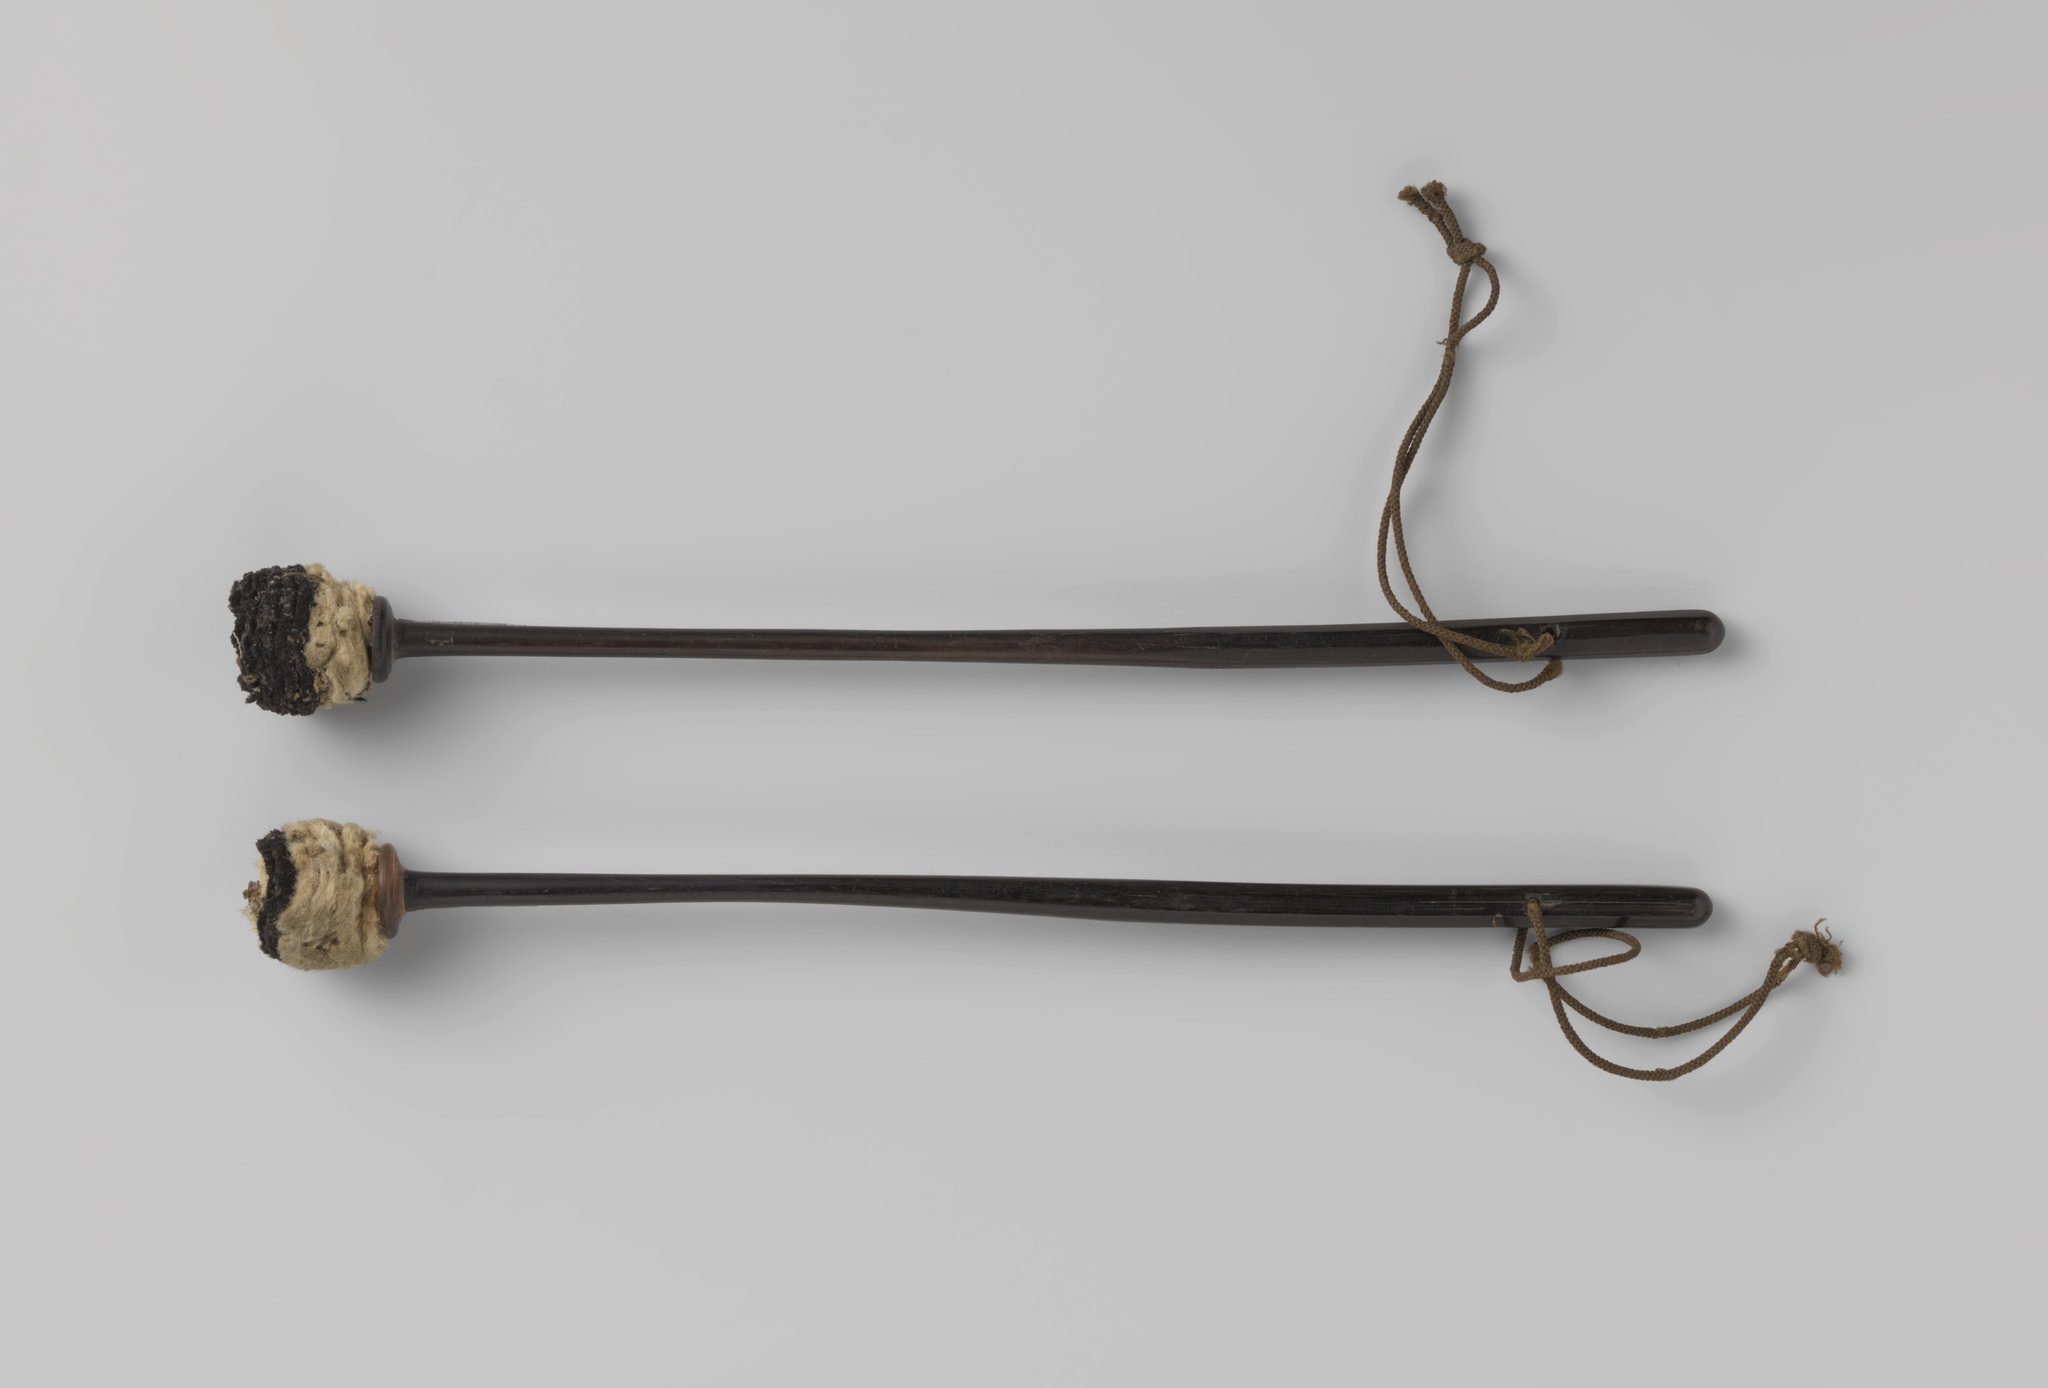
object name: element of musical instrument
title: Timpani hammers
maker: Anonymous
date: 1800-1893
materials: wood, wool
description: Paukenstokken van hout. Horend bij drie paukenstokken (BK-NM-11430-125-A t/m BK-NM-11430-125-D).